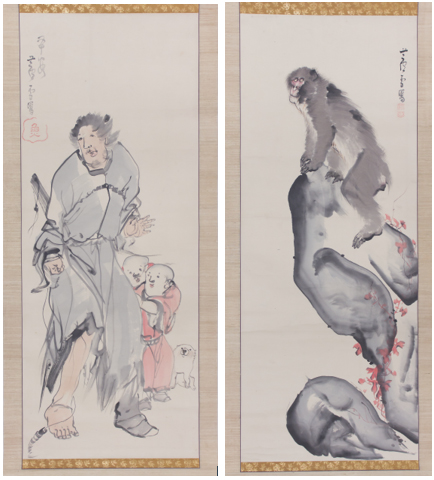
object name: hanging scroll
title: Monkey on a Rock; Monkey Trainer with Chinese Children and Puppy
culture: japanese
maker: nagasawa rosetsu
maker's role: artist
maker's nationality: japanese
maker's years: 1754-1799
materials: ink, paper